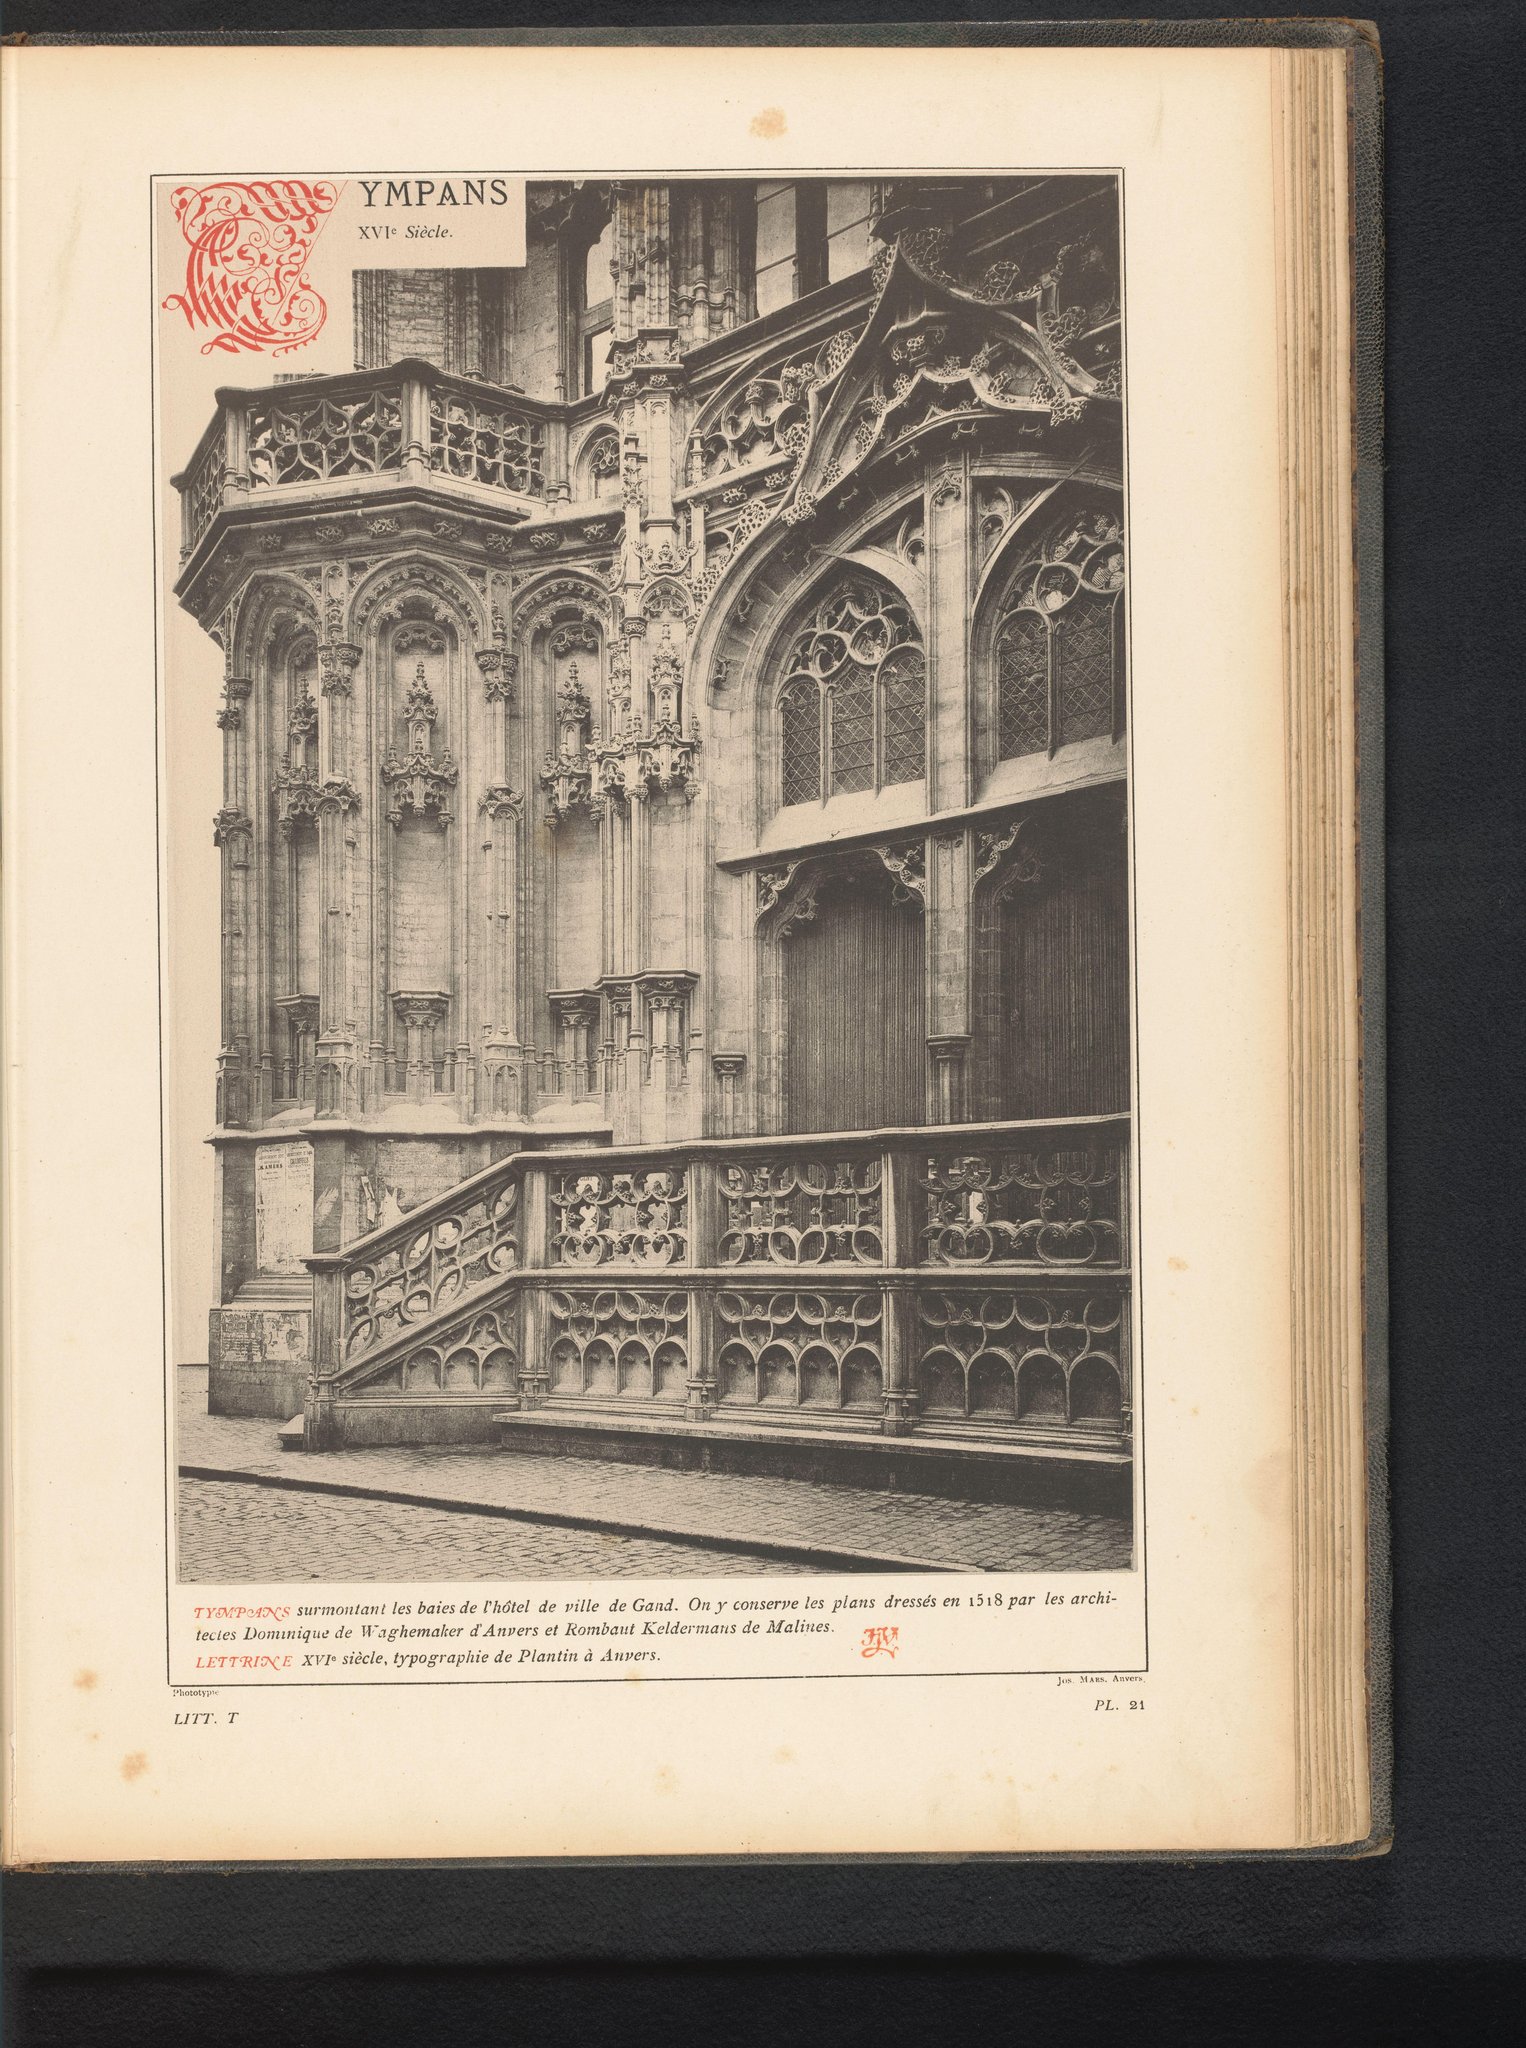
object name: photomechanical print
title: Timpanen van het stadhuis van Gent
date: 1876-1881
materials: paper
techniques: photograph, photolithography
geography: antwerp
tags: parts of church exterior and annexes: tympanum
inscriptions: inscription: ‘LITT. T. - PL. 21.’, inscription: ‘TYMPANS surmontant les (...)’, monogram: ‘JJvY’